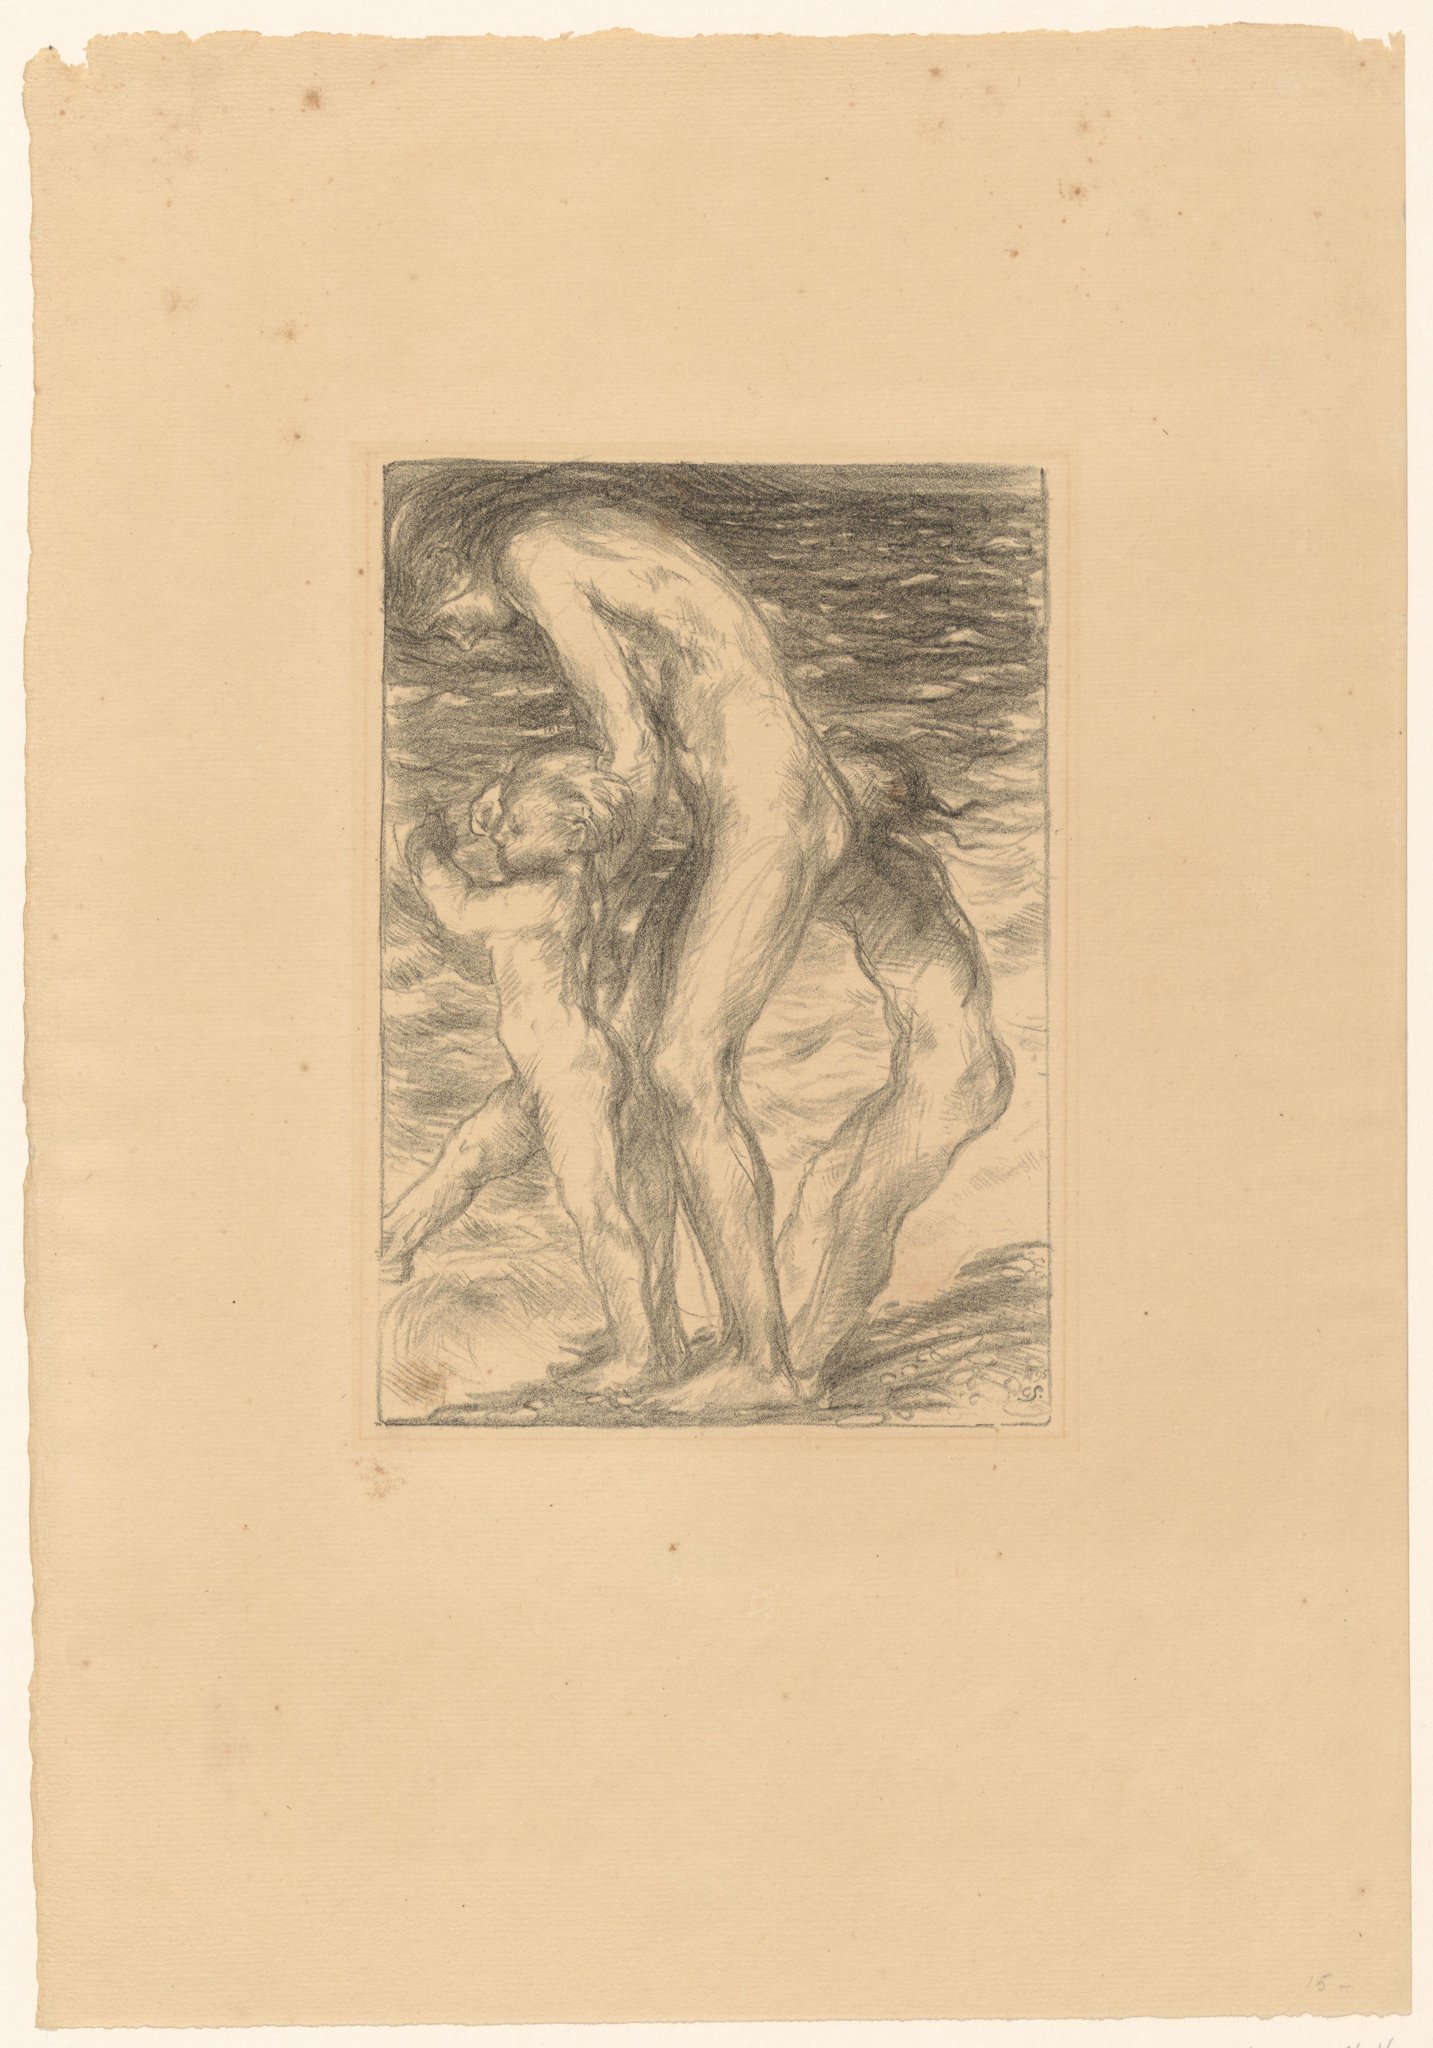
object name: print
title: Salt water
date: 1896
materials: paper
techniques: lithograph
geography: london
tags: the (nude) human figure; 'corpo humano' (ripa), mother and child(ren), woman and child(ren) (family group), beach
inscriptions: collector's mark: Lugt 2228